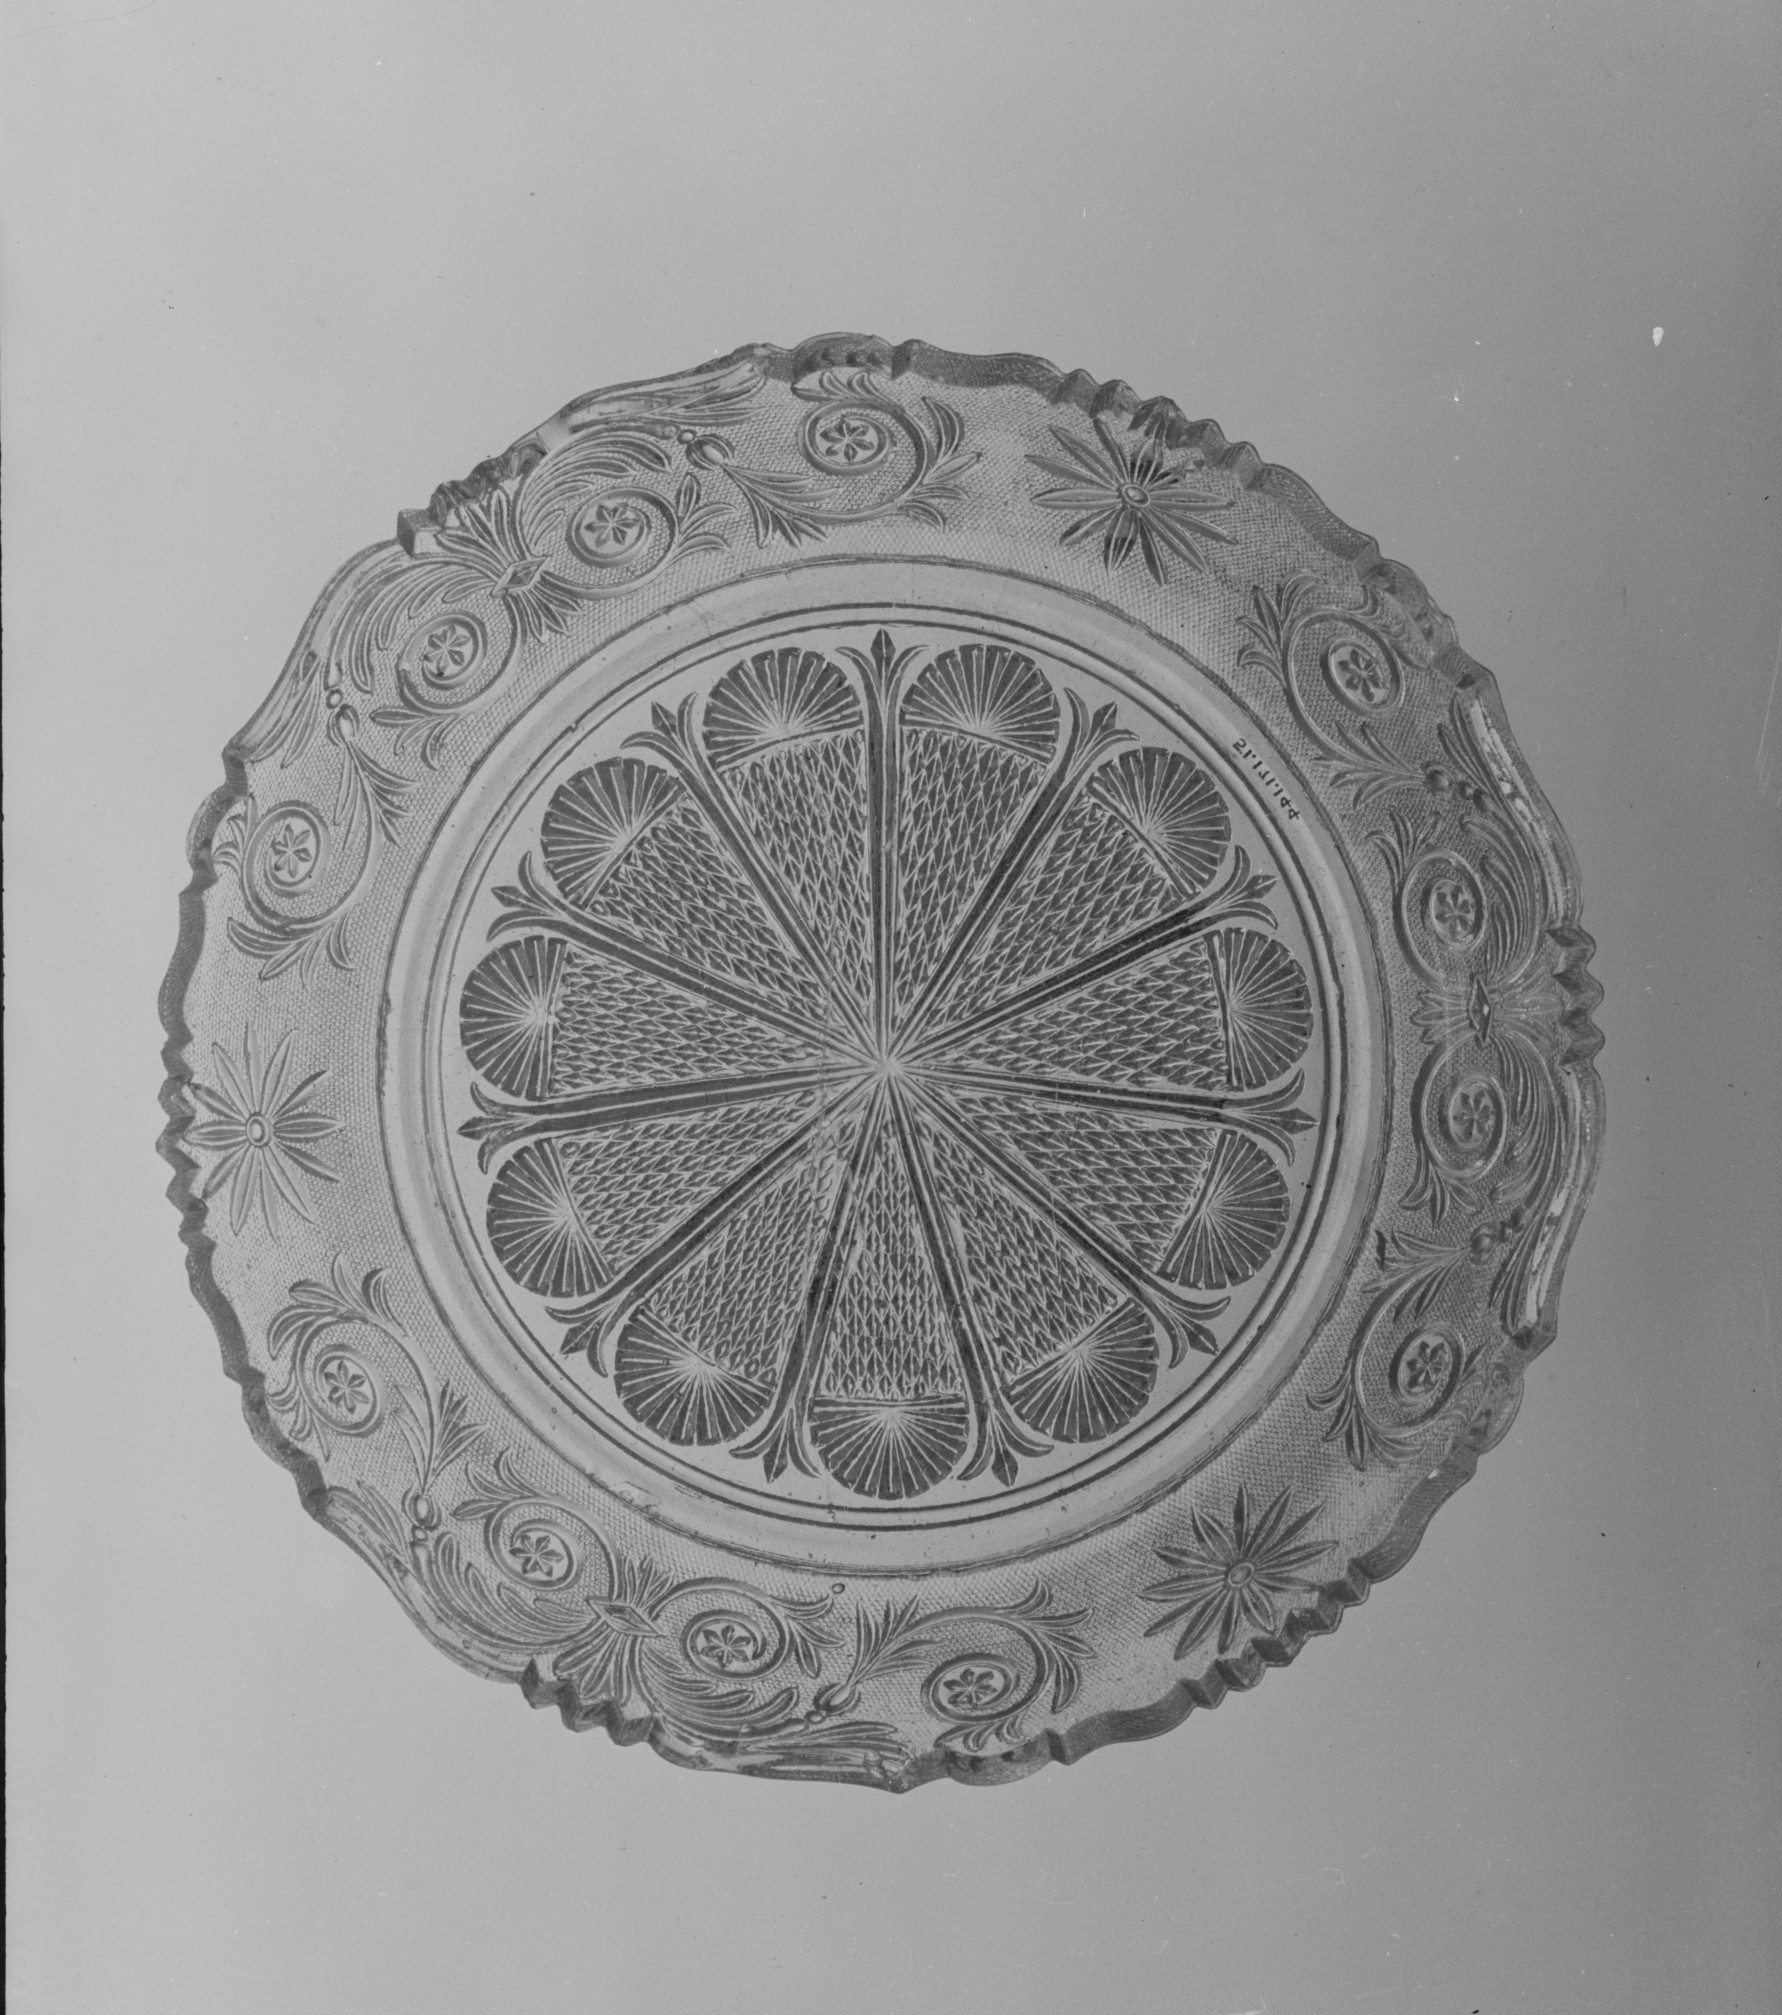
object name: bowl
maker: cristalleries de saint-louis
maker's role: maker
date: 1835-1850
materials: glass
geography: france